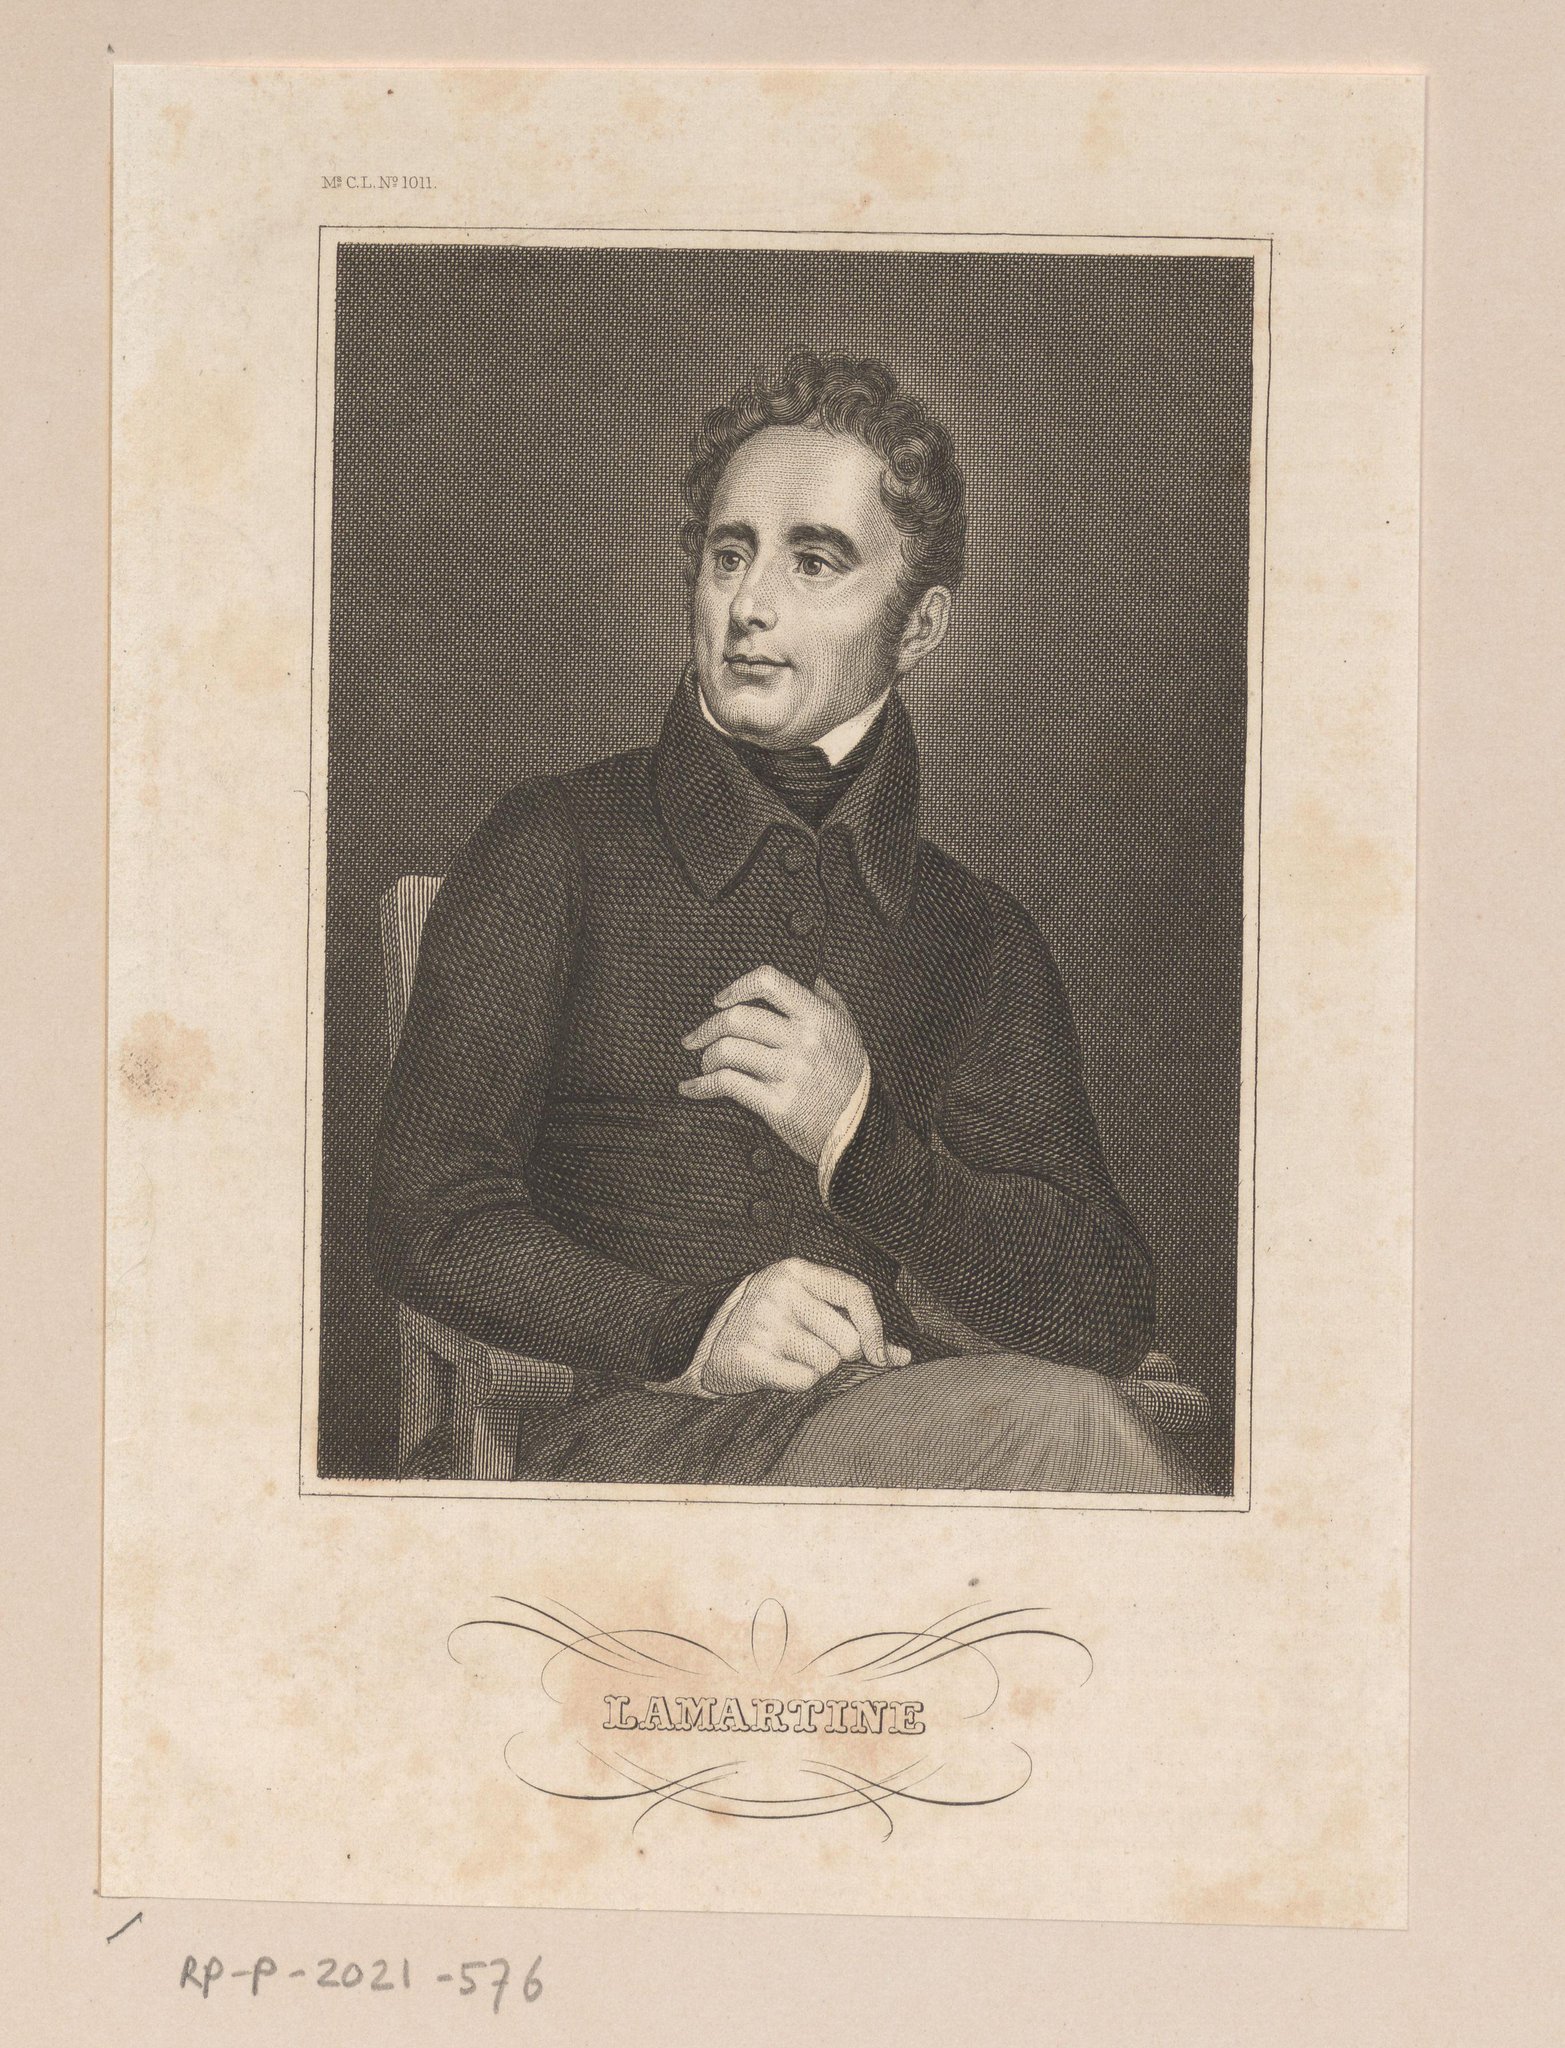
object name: print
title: Portret van Alphonse de Lamartine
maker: Anonymous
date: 1828-1852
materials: paper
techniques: engraving, etching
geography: germany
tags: paris, historical persons, portrait of a writer, politician, e.g. party leader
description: Prent waarschijnlijk uit: Meyer, Joseph. Das große Conversations-Lexikon für die gebildeten Stände. 52 dln. Hildburghausen: Bibliographisches Institut, 1828-1852.